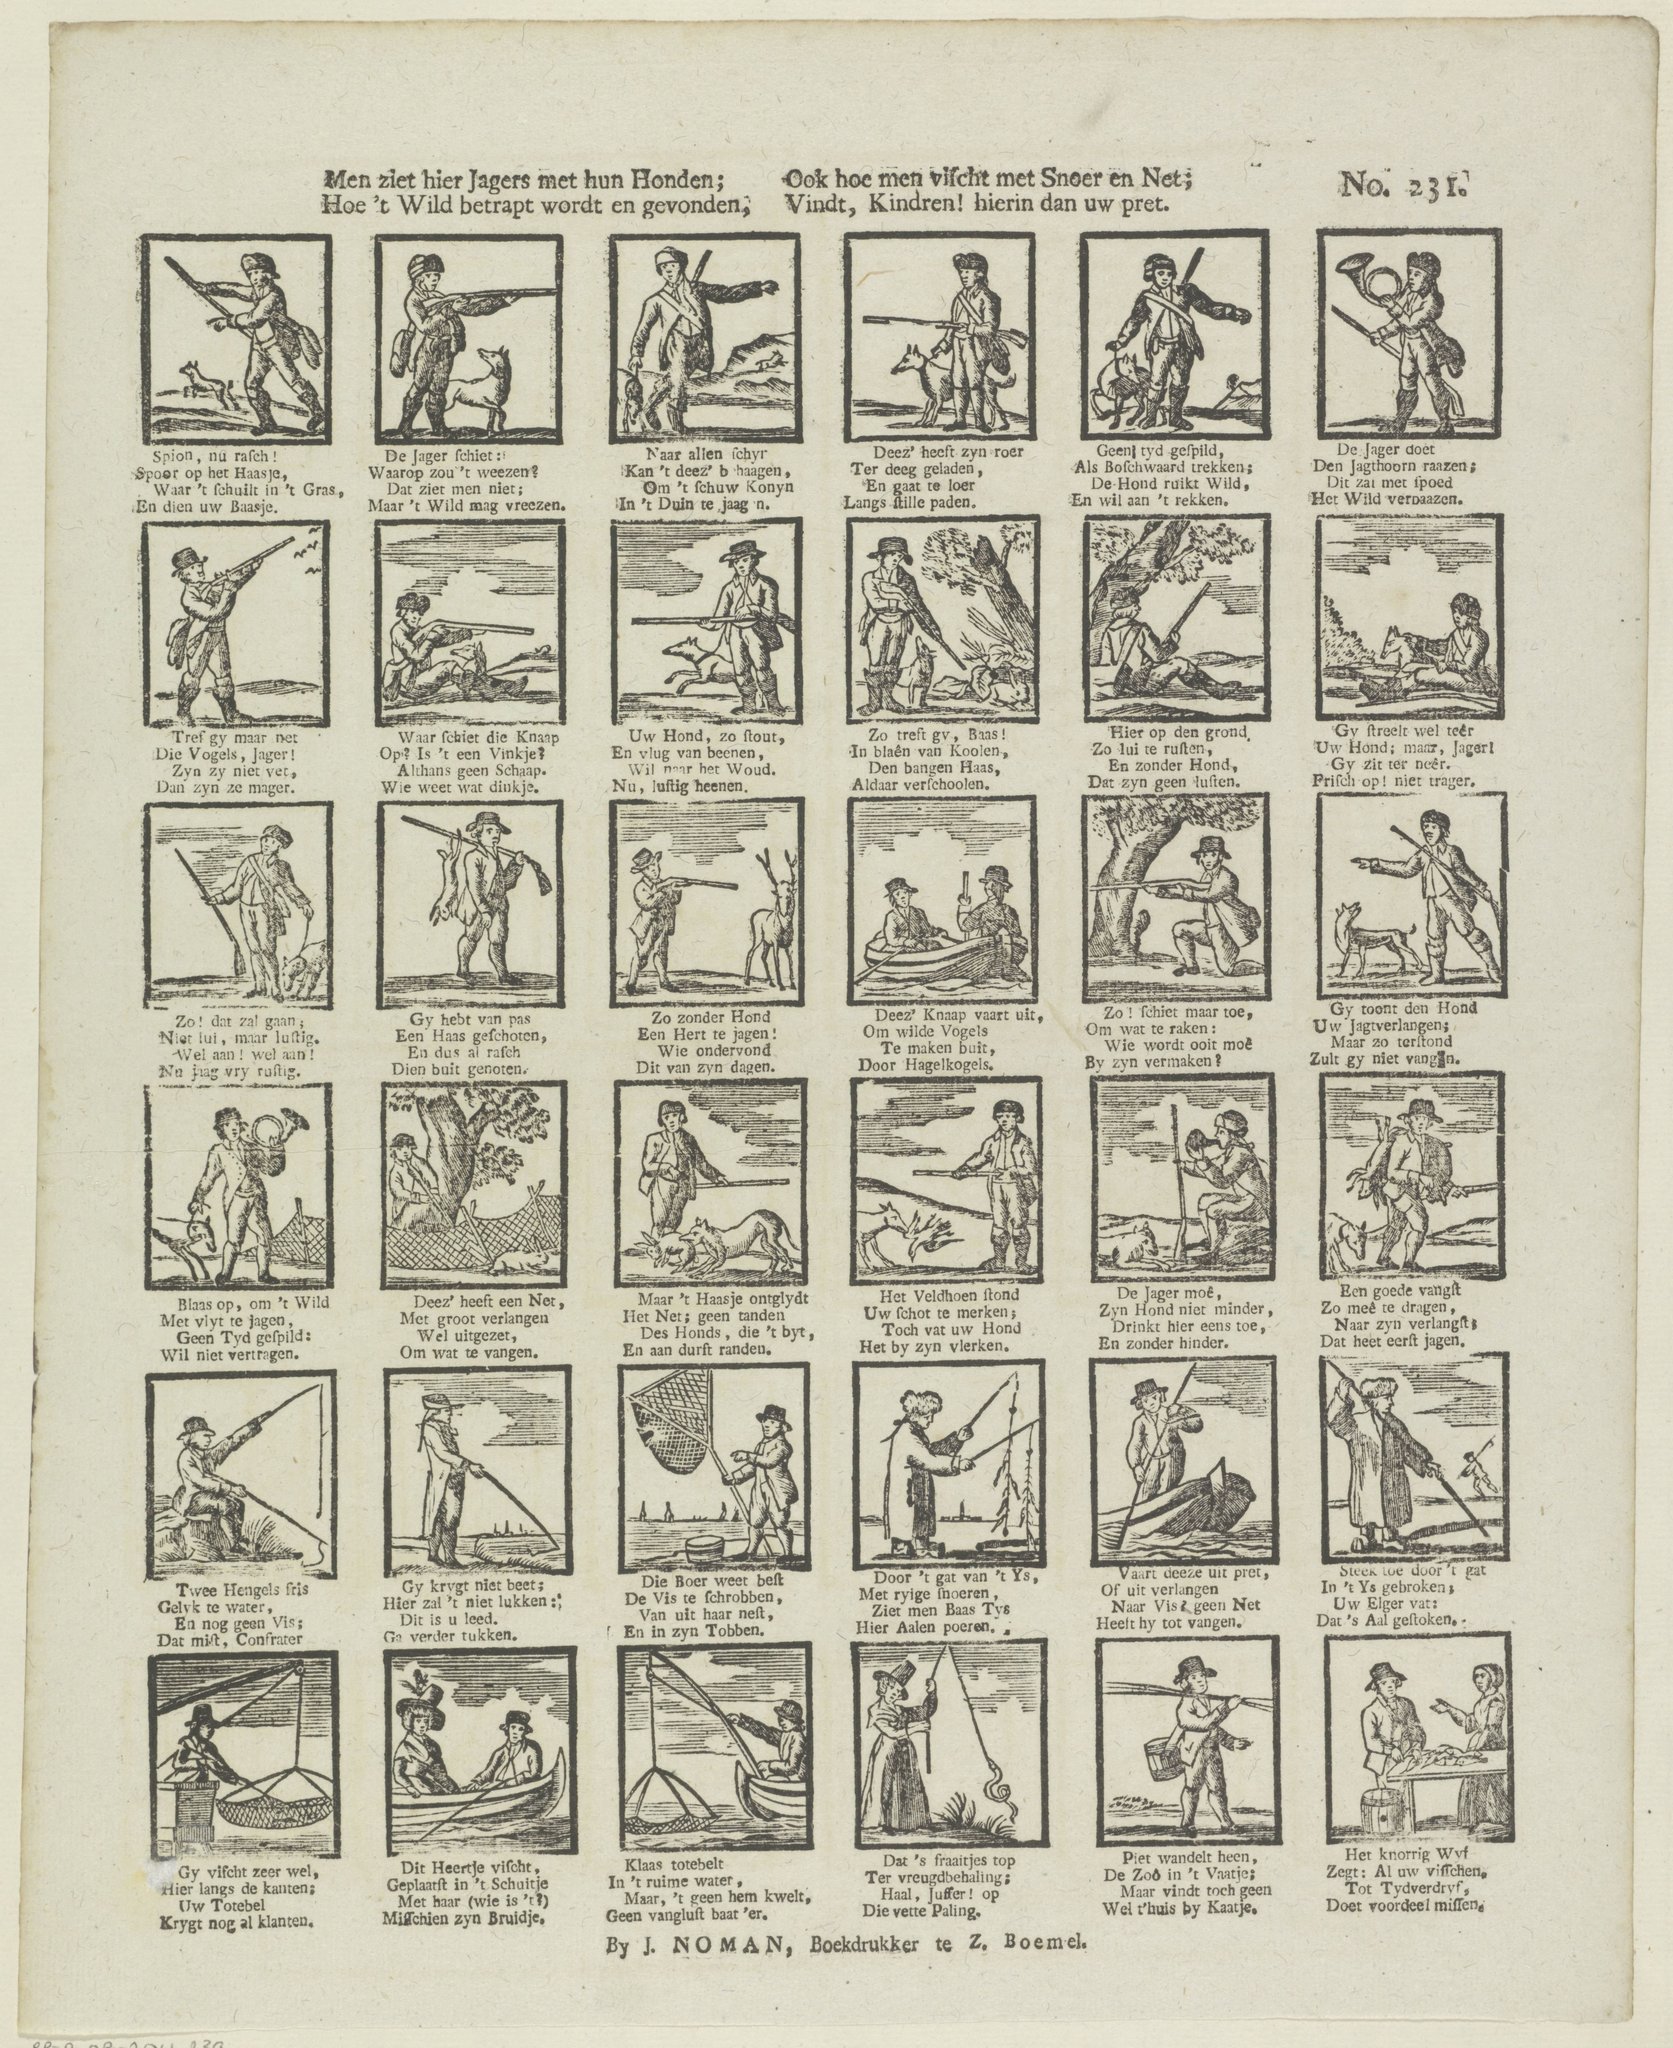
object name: print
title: Men ziet hier jagers met hun honden; / Hoe 't wild betrapt wordt en gevonden, / Ook hoe men vischt met snoer en net; / Vindt, kindren! hierin dan uw pret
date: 1806-1830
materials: paper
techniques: letterpress printing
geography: netherlands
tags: hunting dogs, hunter, hunters hunting (n.b.: in 1988-1990 this notation denoted the concept of 43c11421 'hunters resting during the hunt'), fisherman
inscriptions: collector's mark: Lugt 2760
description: Blad met 36 voorstellingen van jagers en vissers. Onder elke afbeelding een vierregelig vers. Genummerd rechtsboven: No. 231.